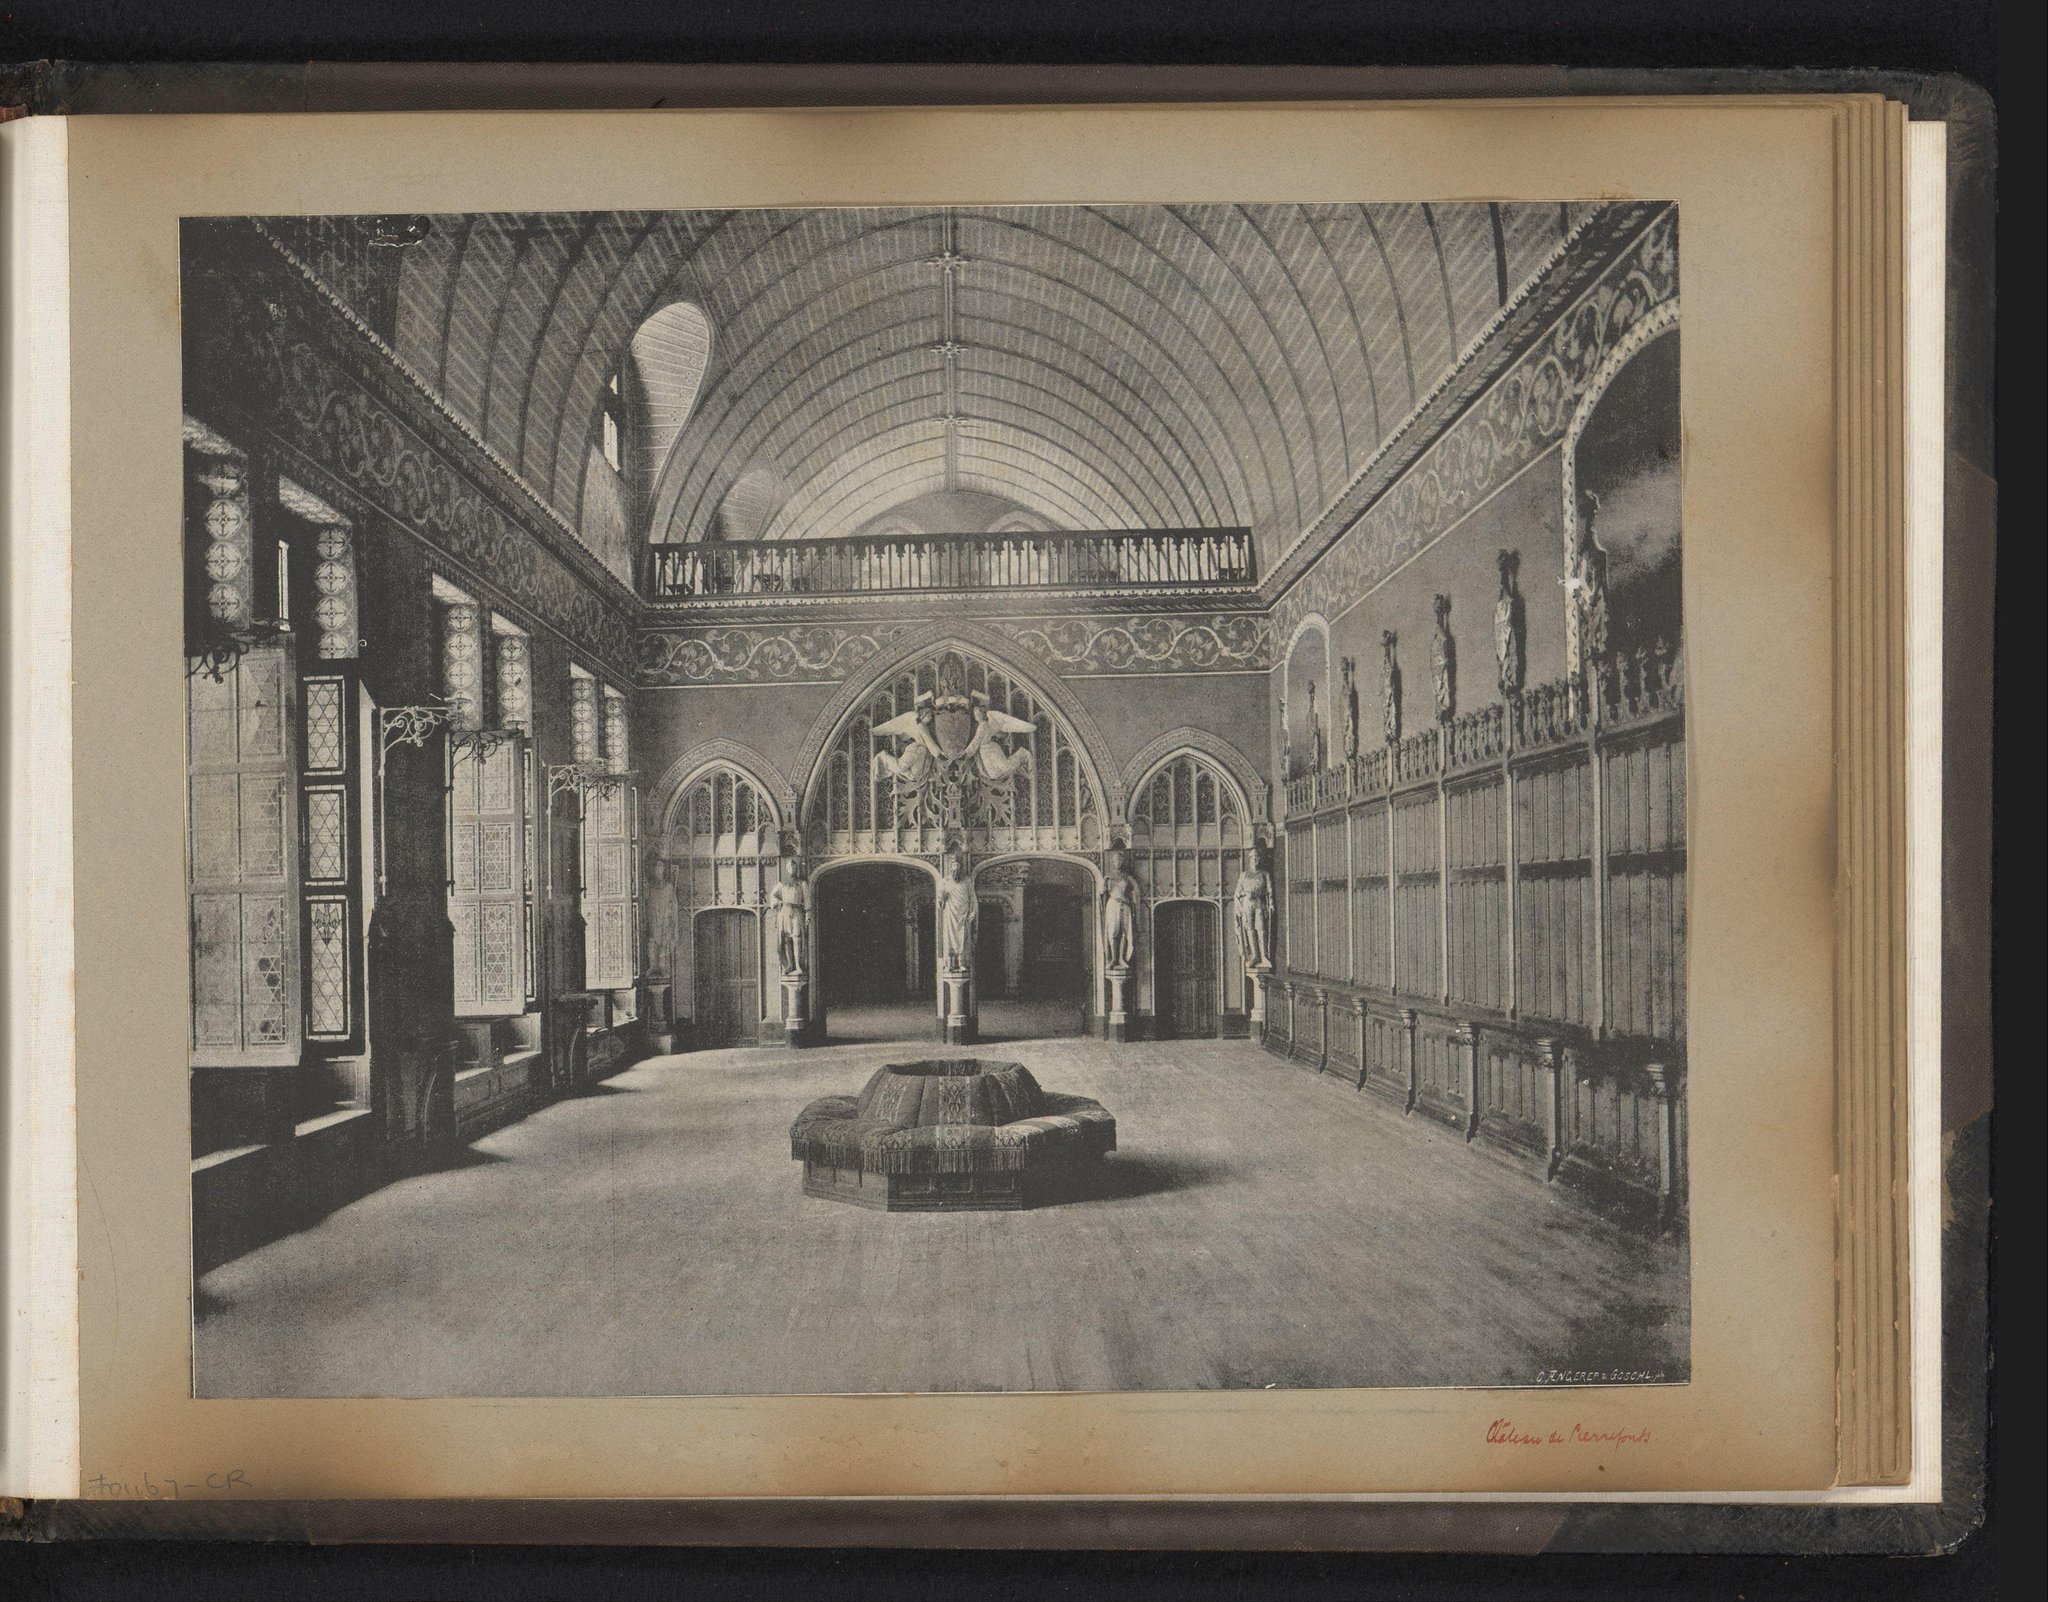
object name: photomechanical print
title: Interieur van het kasteel van Pierrefonds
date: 1880-1900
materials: paper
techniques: autotype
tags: castle - aa - civic architecture: inside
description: Deze prent maakt deel uit van een album.